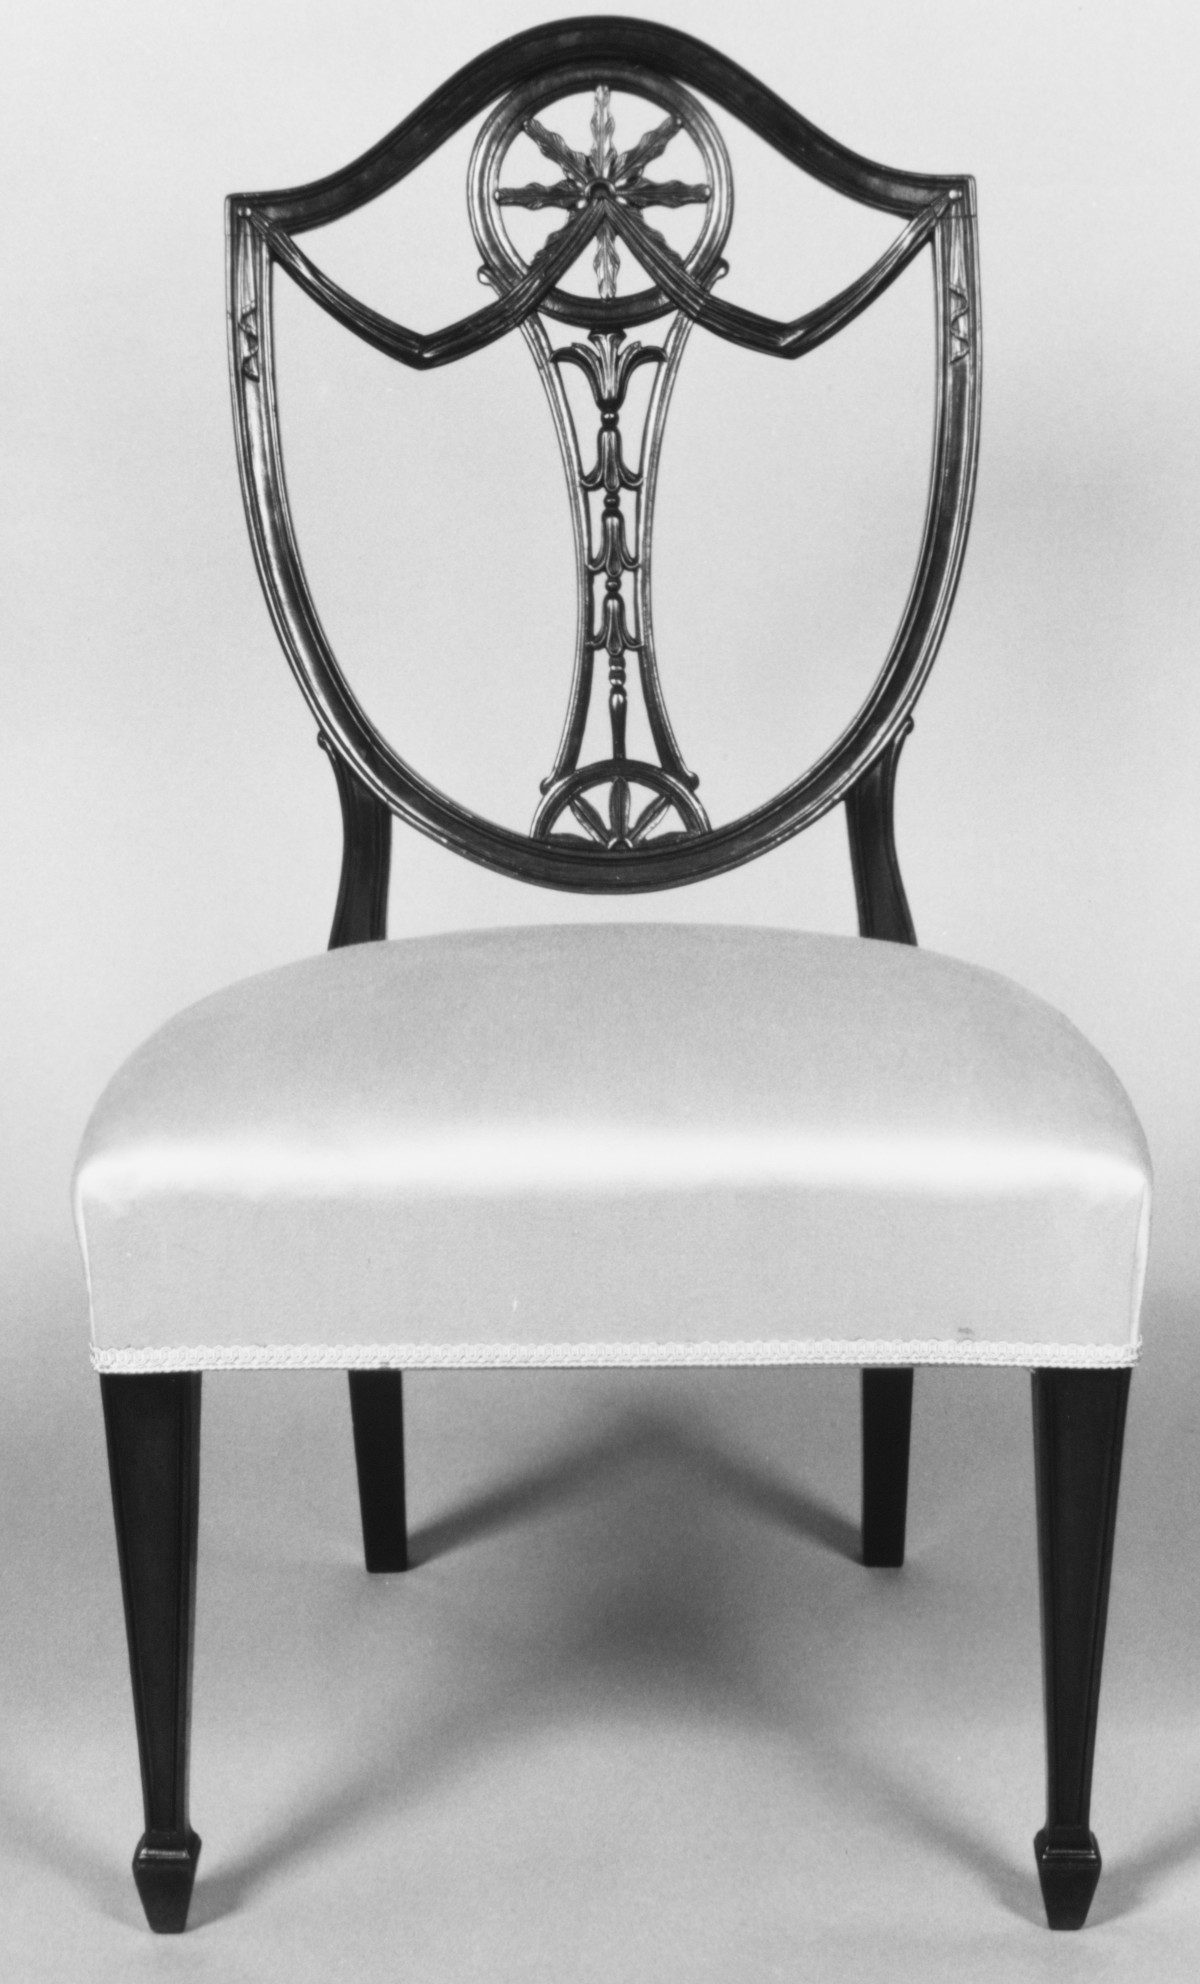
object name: side chair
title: Miniature side chairs (part of a set)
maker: pierre-eloi langlois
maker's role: maker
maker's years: 1738-1805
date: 1795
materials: wood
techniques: veneering